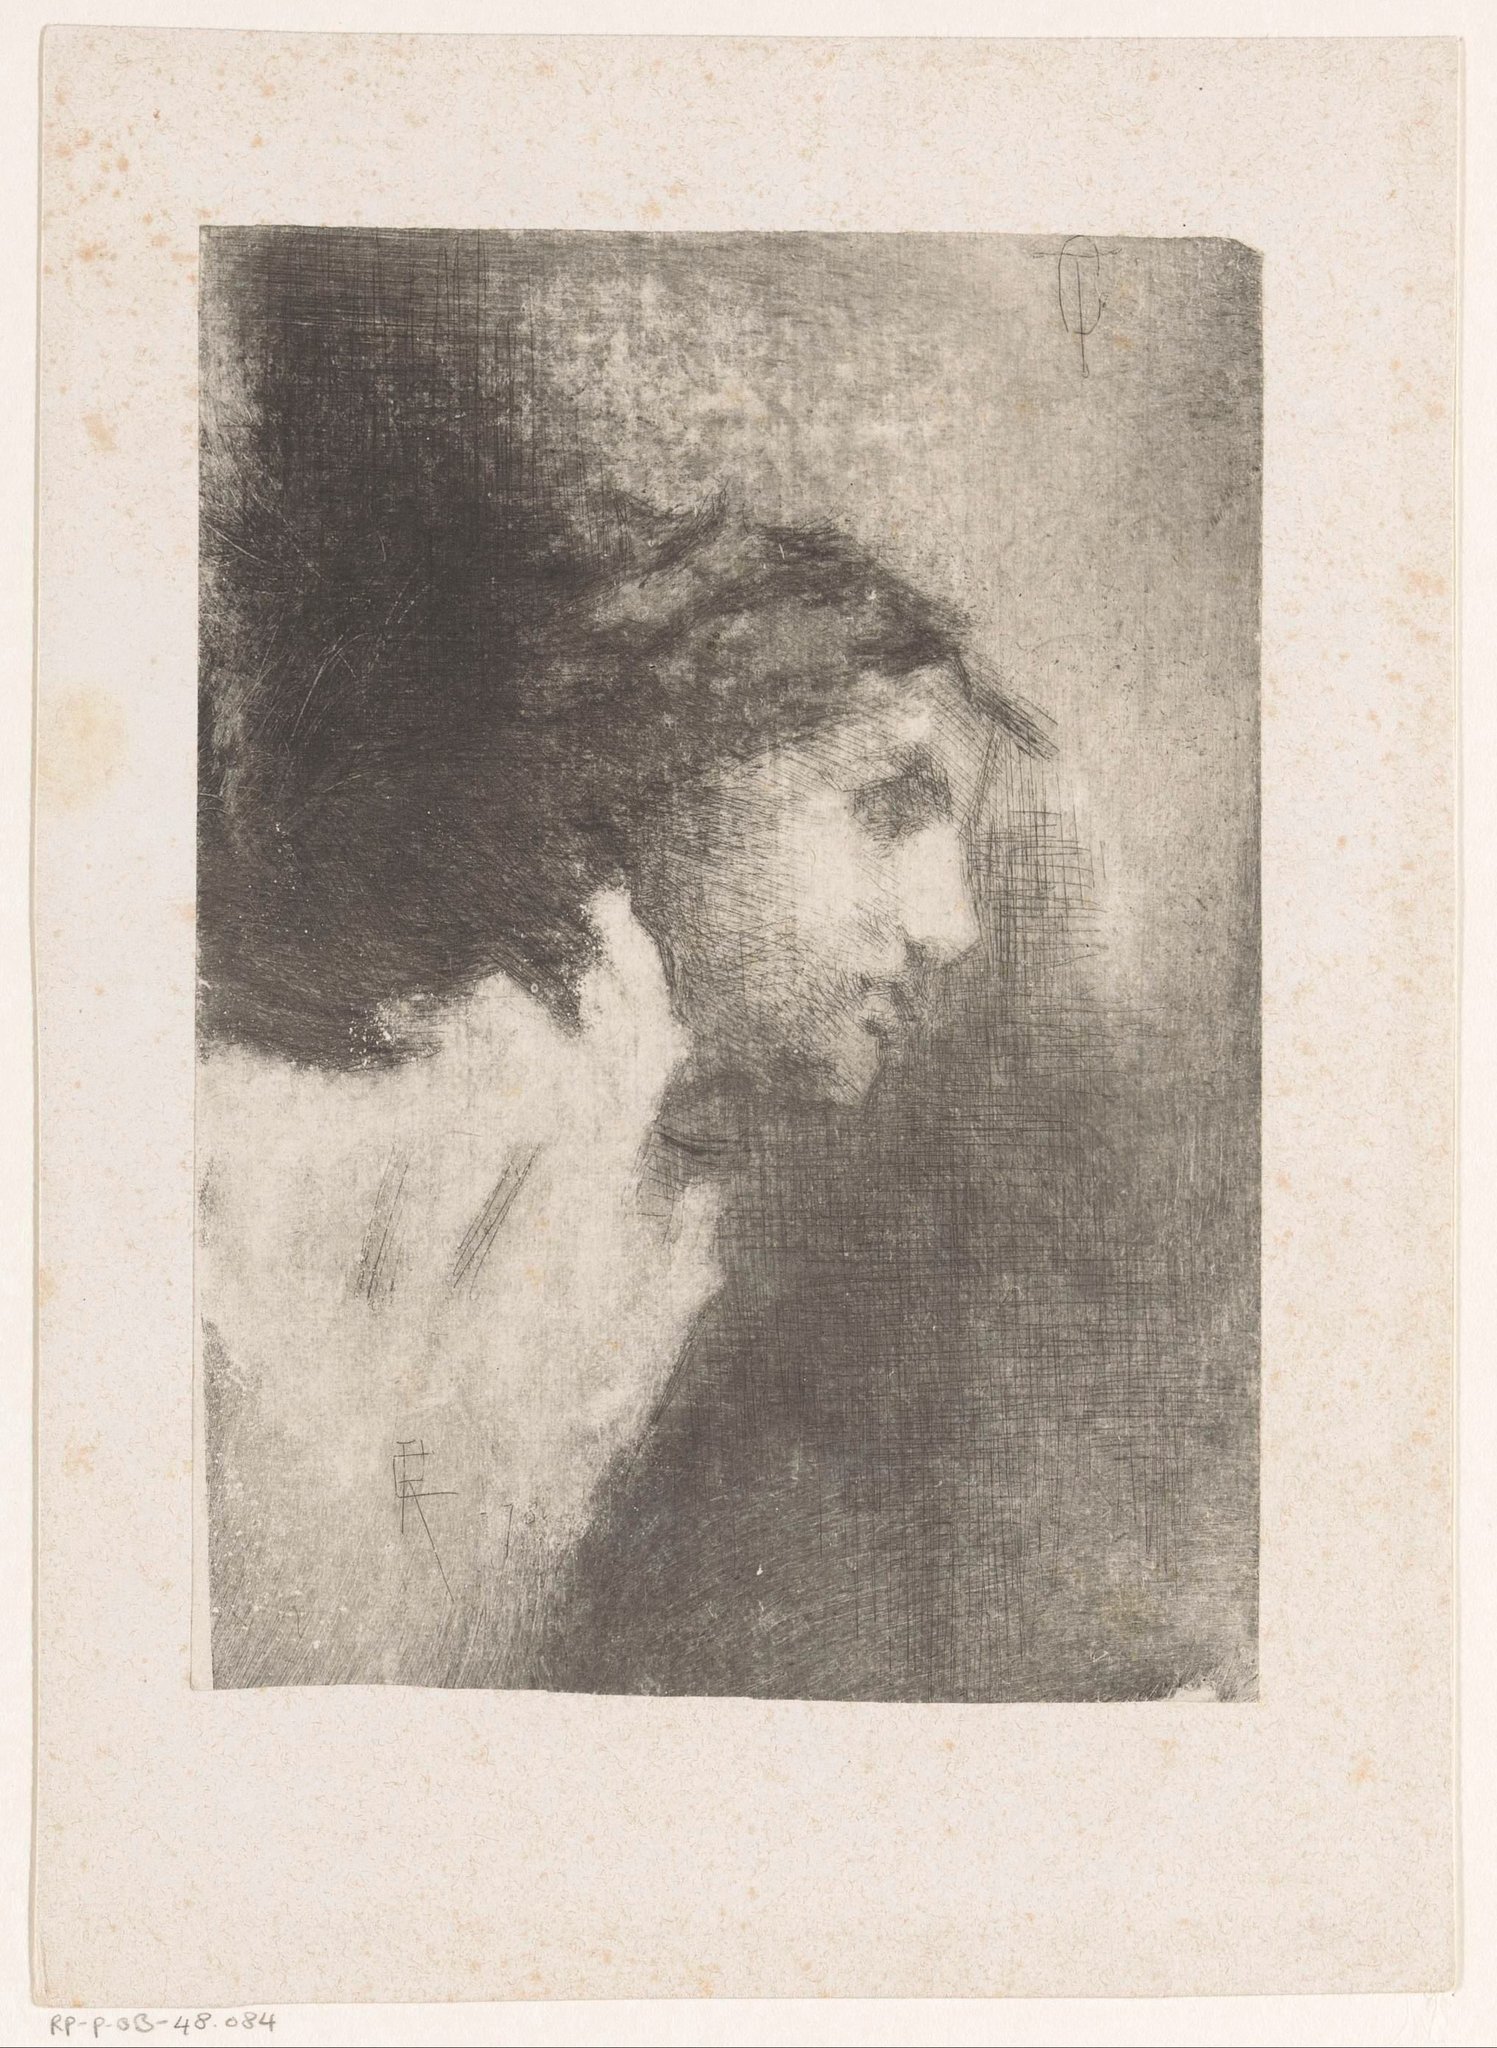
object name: print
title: Hoofd van een vrouw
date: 1878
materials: paper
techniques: aquatint, etching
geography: spain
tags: head (human) - aa - female human figure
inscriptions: collector's mark: Lugt 2228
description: De prent is voorzien van een imitatieplaatrand.